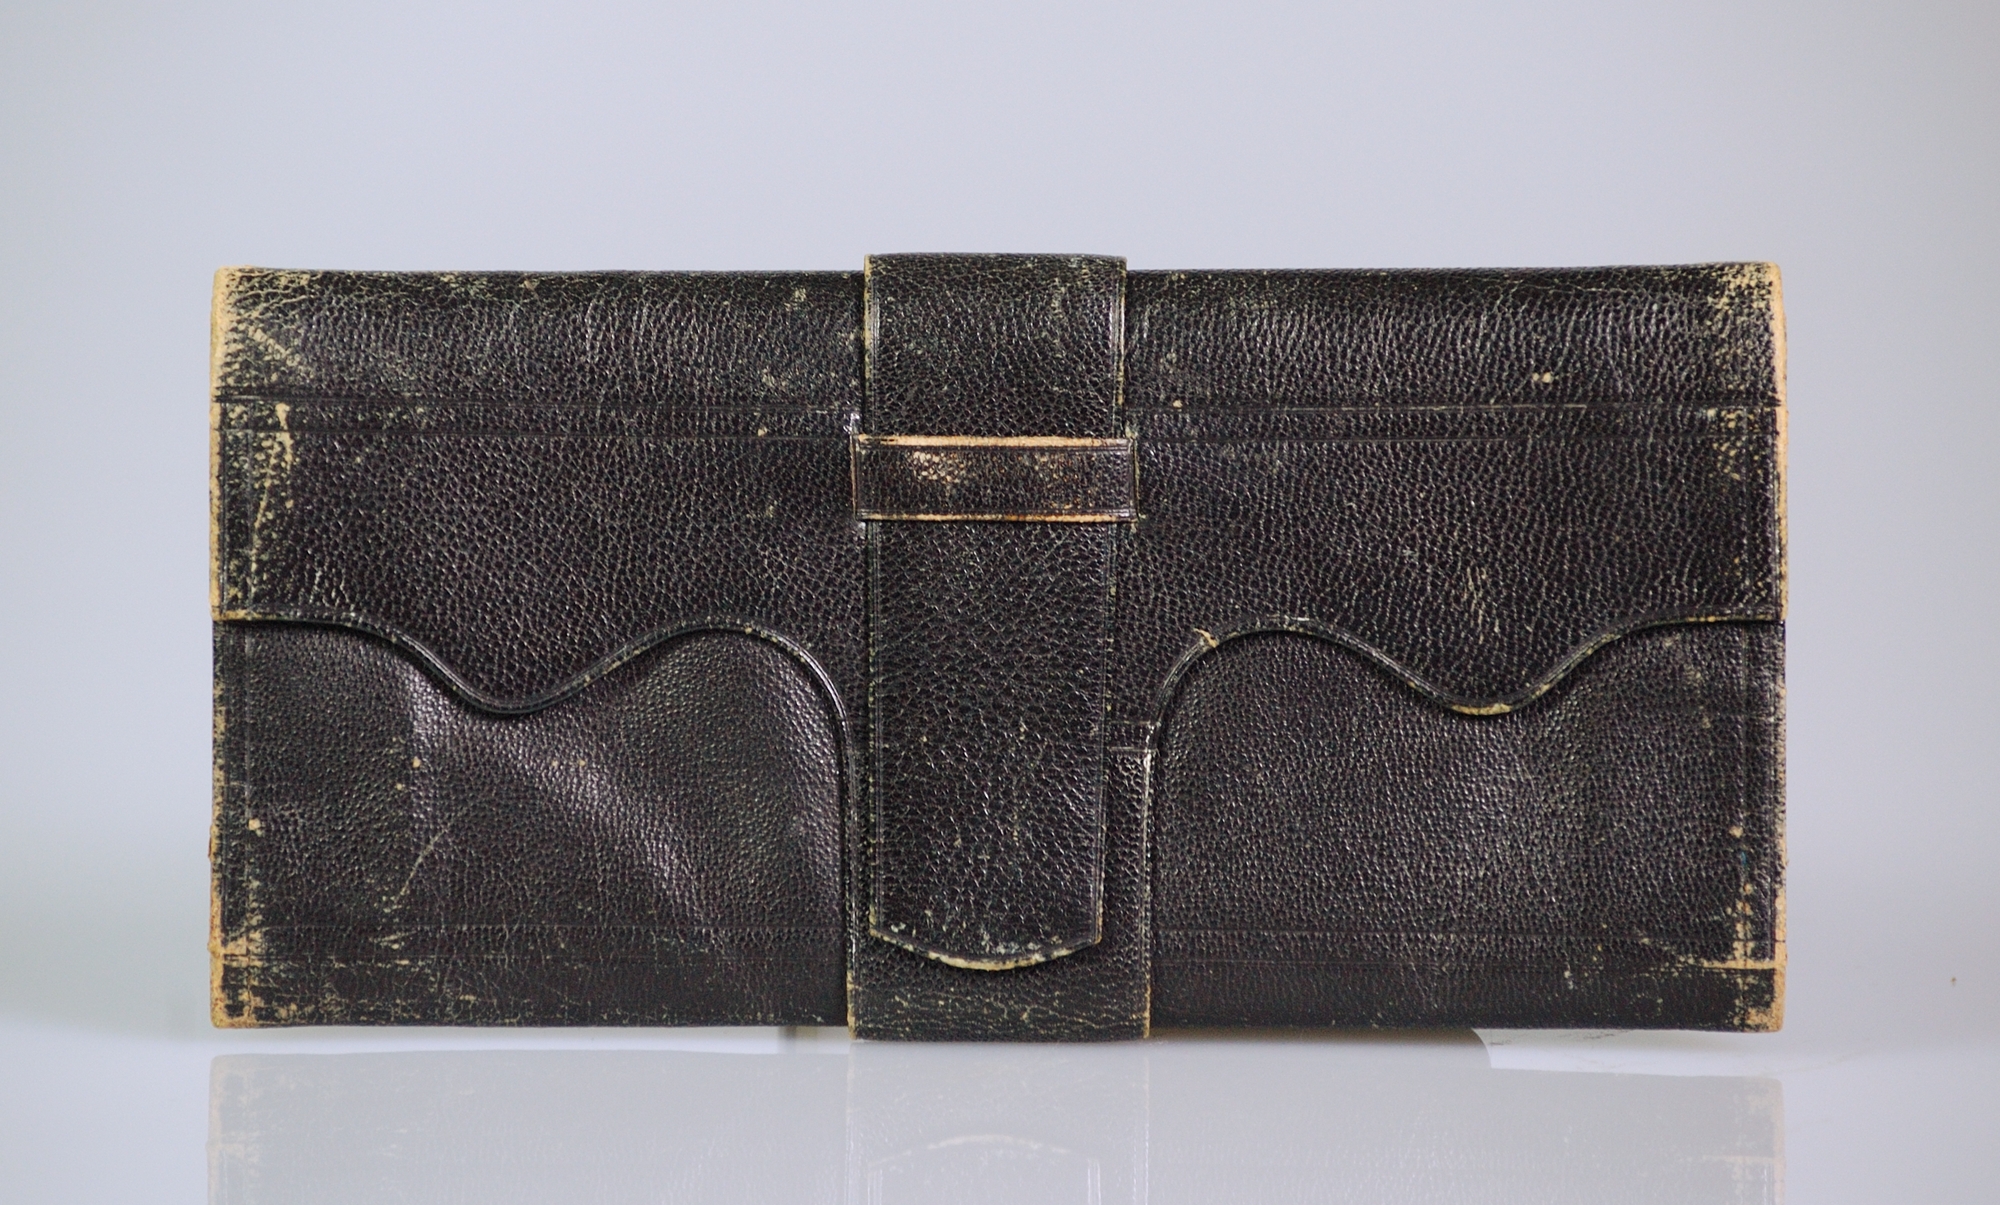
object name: wallet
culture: french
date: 1860-1869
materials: leather